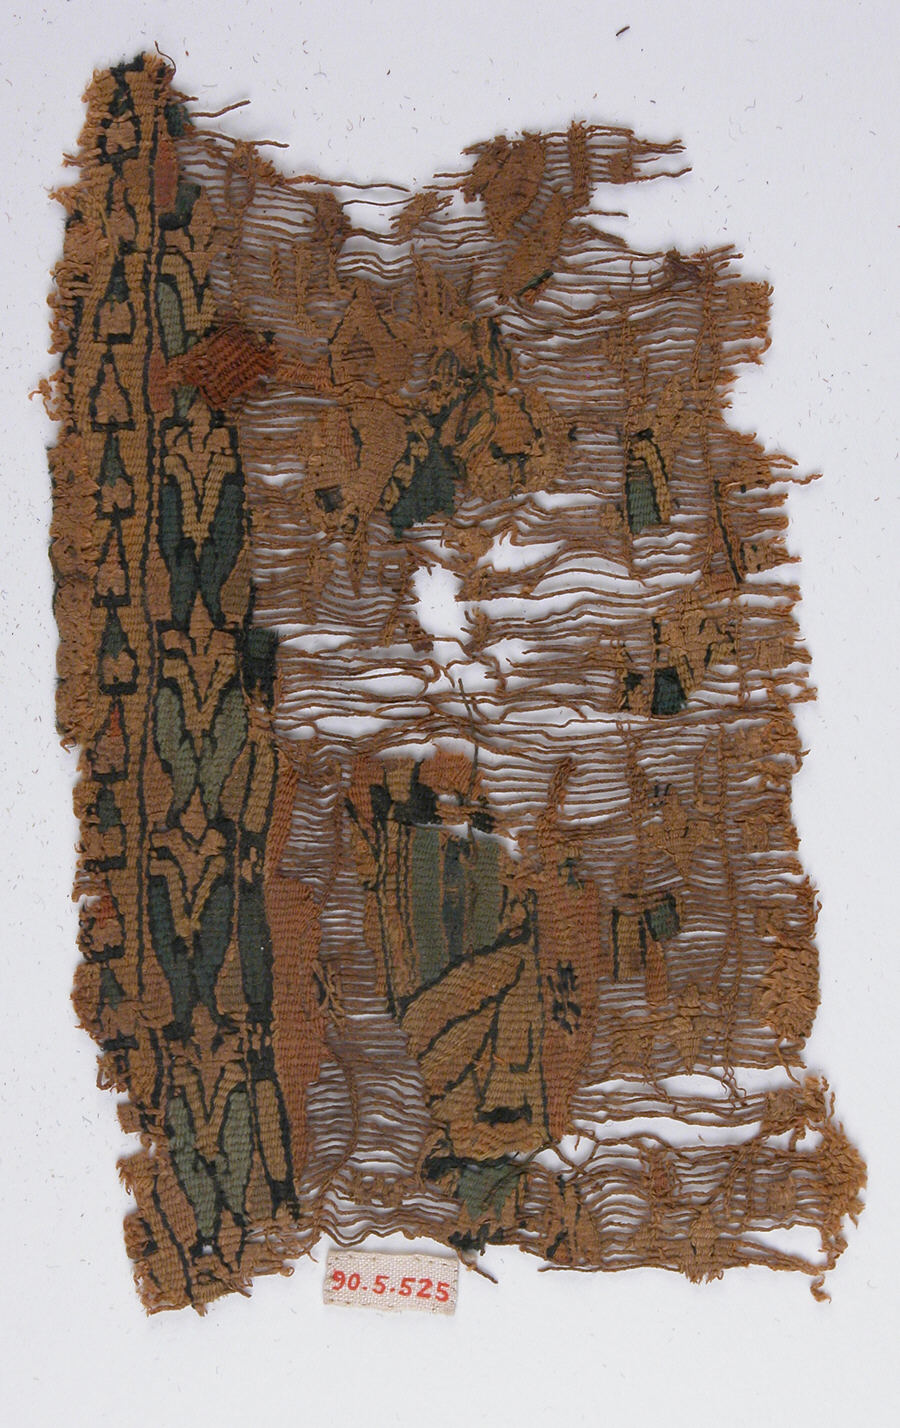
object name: textile fragment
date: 501-700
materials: linen, wool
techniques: weave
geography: egypt